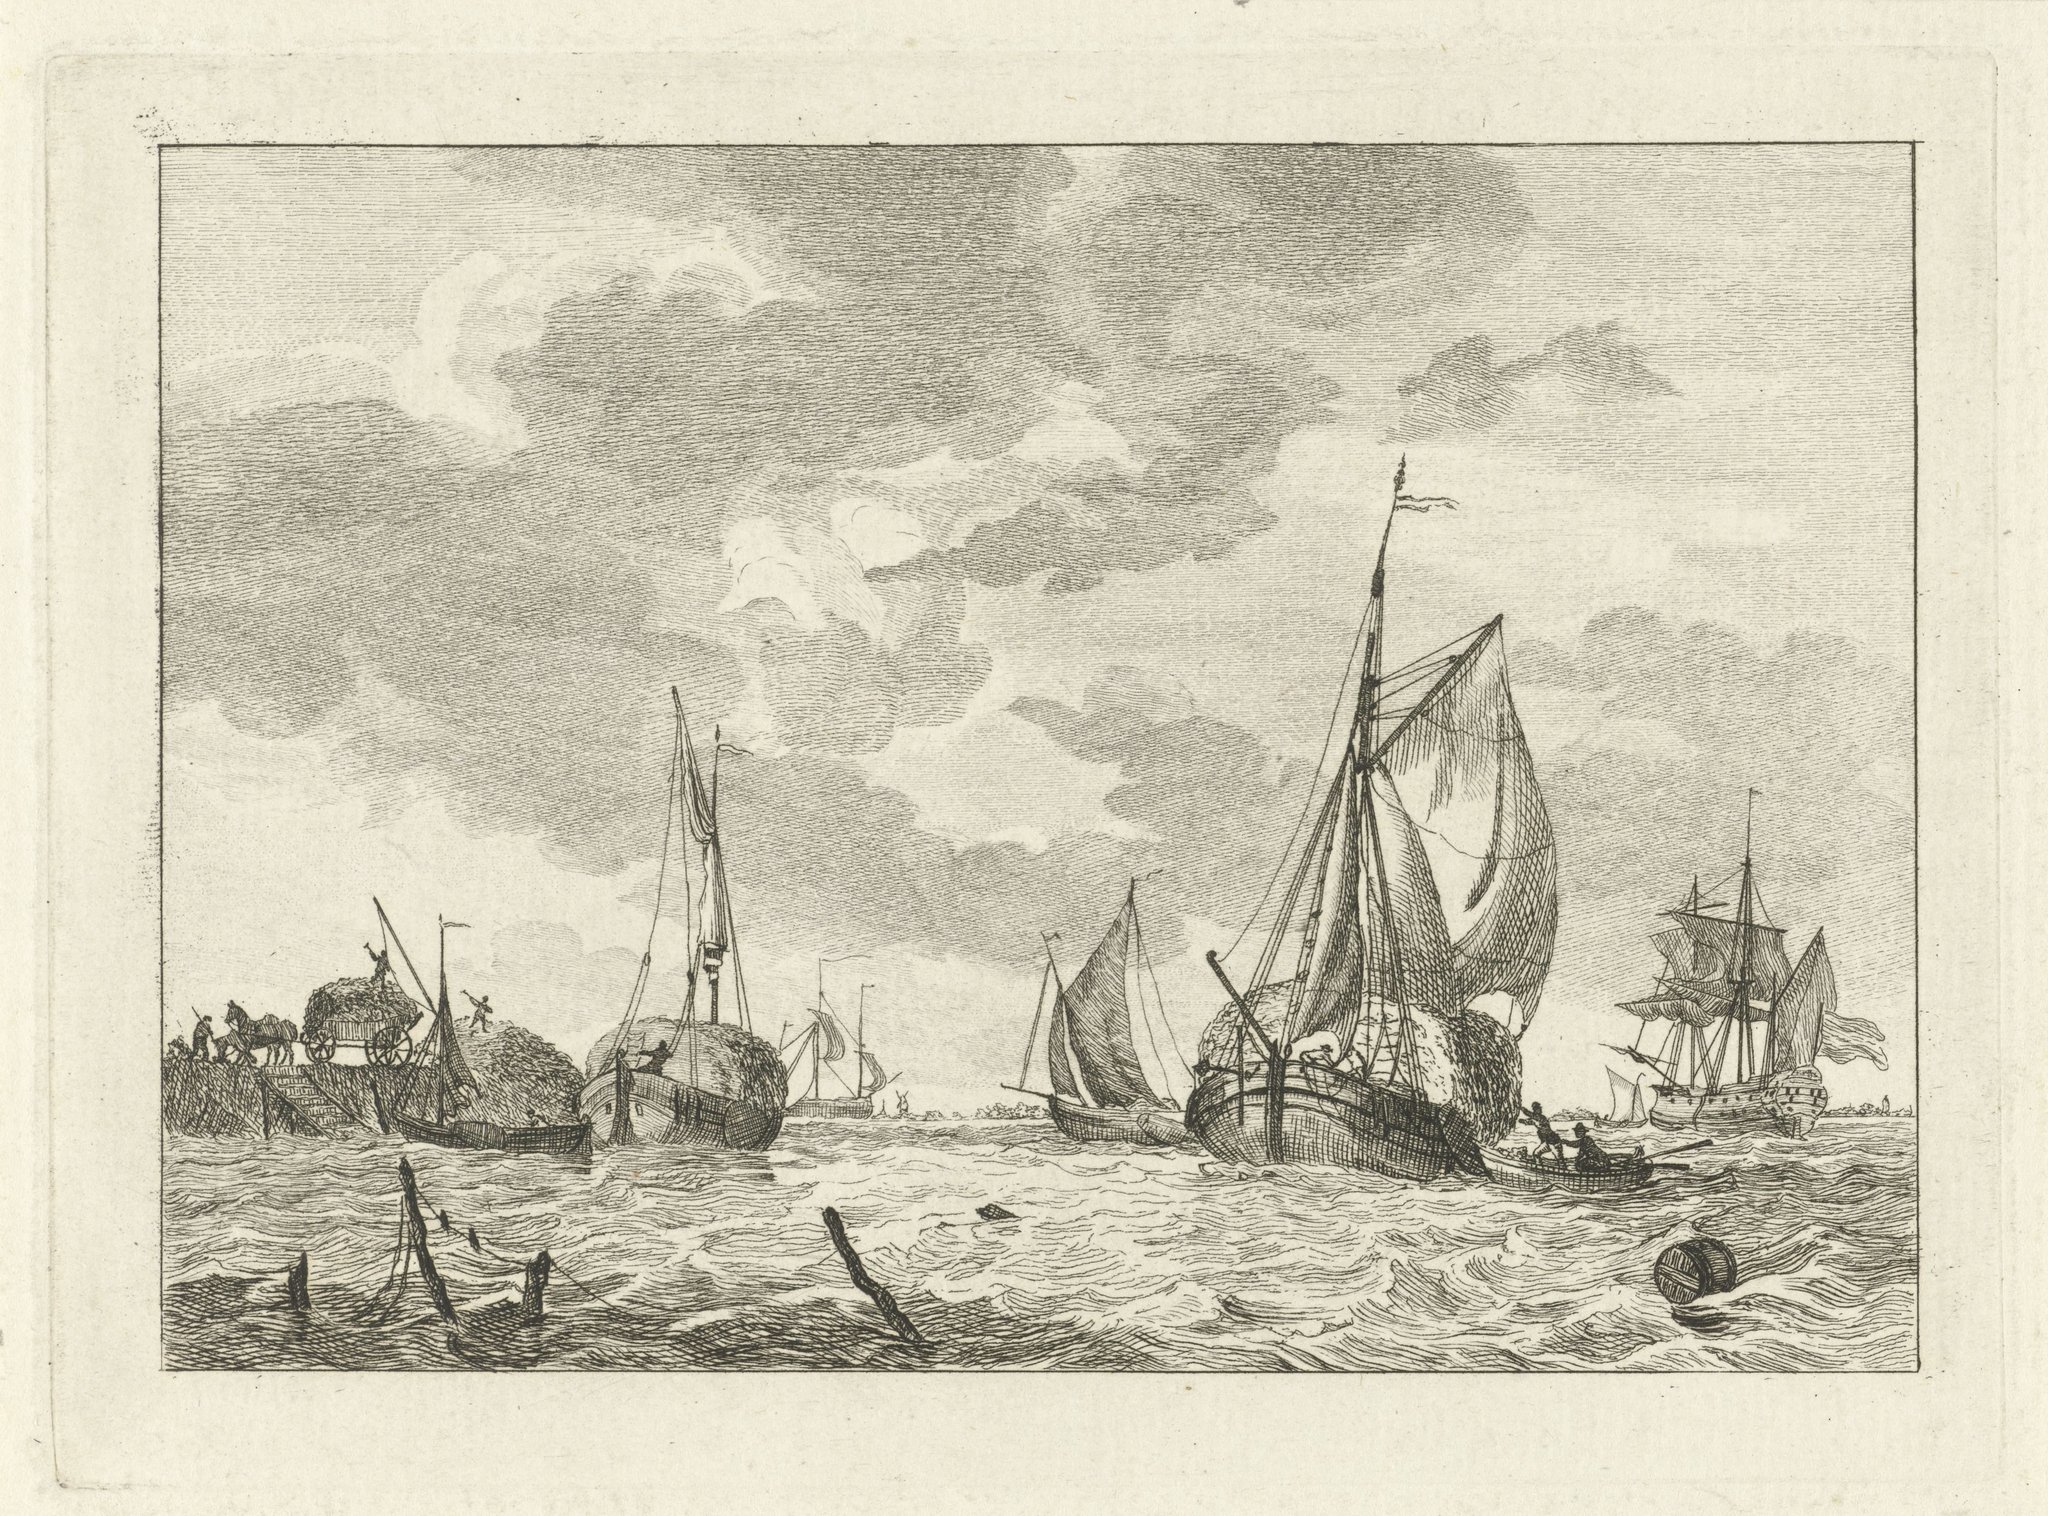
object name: print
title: Zes schepen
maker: gerrit groenewegen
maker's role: draughtsman, print maker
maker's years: 1754-1826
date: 1764-1826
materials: paper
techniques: engraving, etching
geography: rotterdam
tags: ships (in general)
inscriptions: collector's mark: Lugt 2228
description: Zes schepen op het water, waarvan er een aan wal ligt. Drie van de zes schepen zijn volgeladen. Links op de wal staat een paard met wagen.